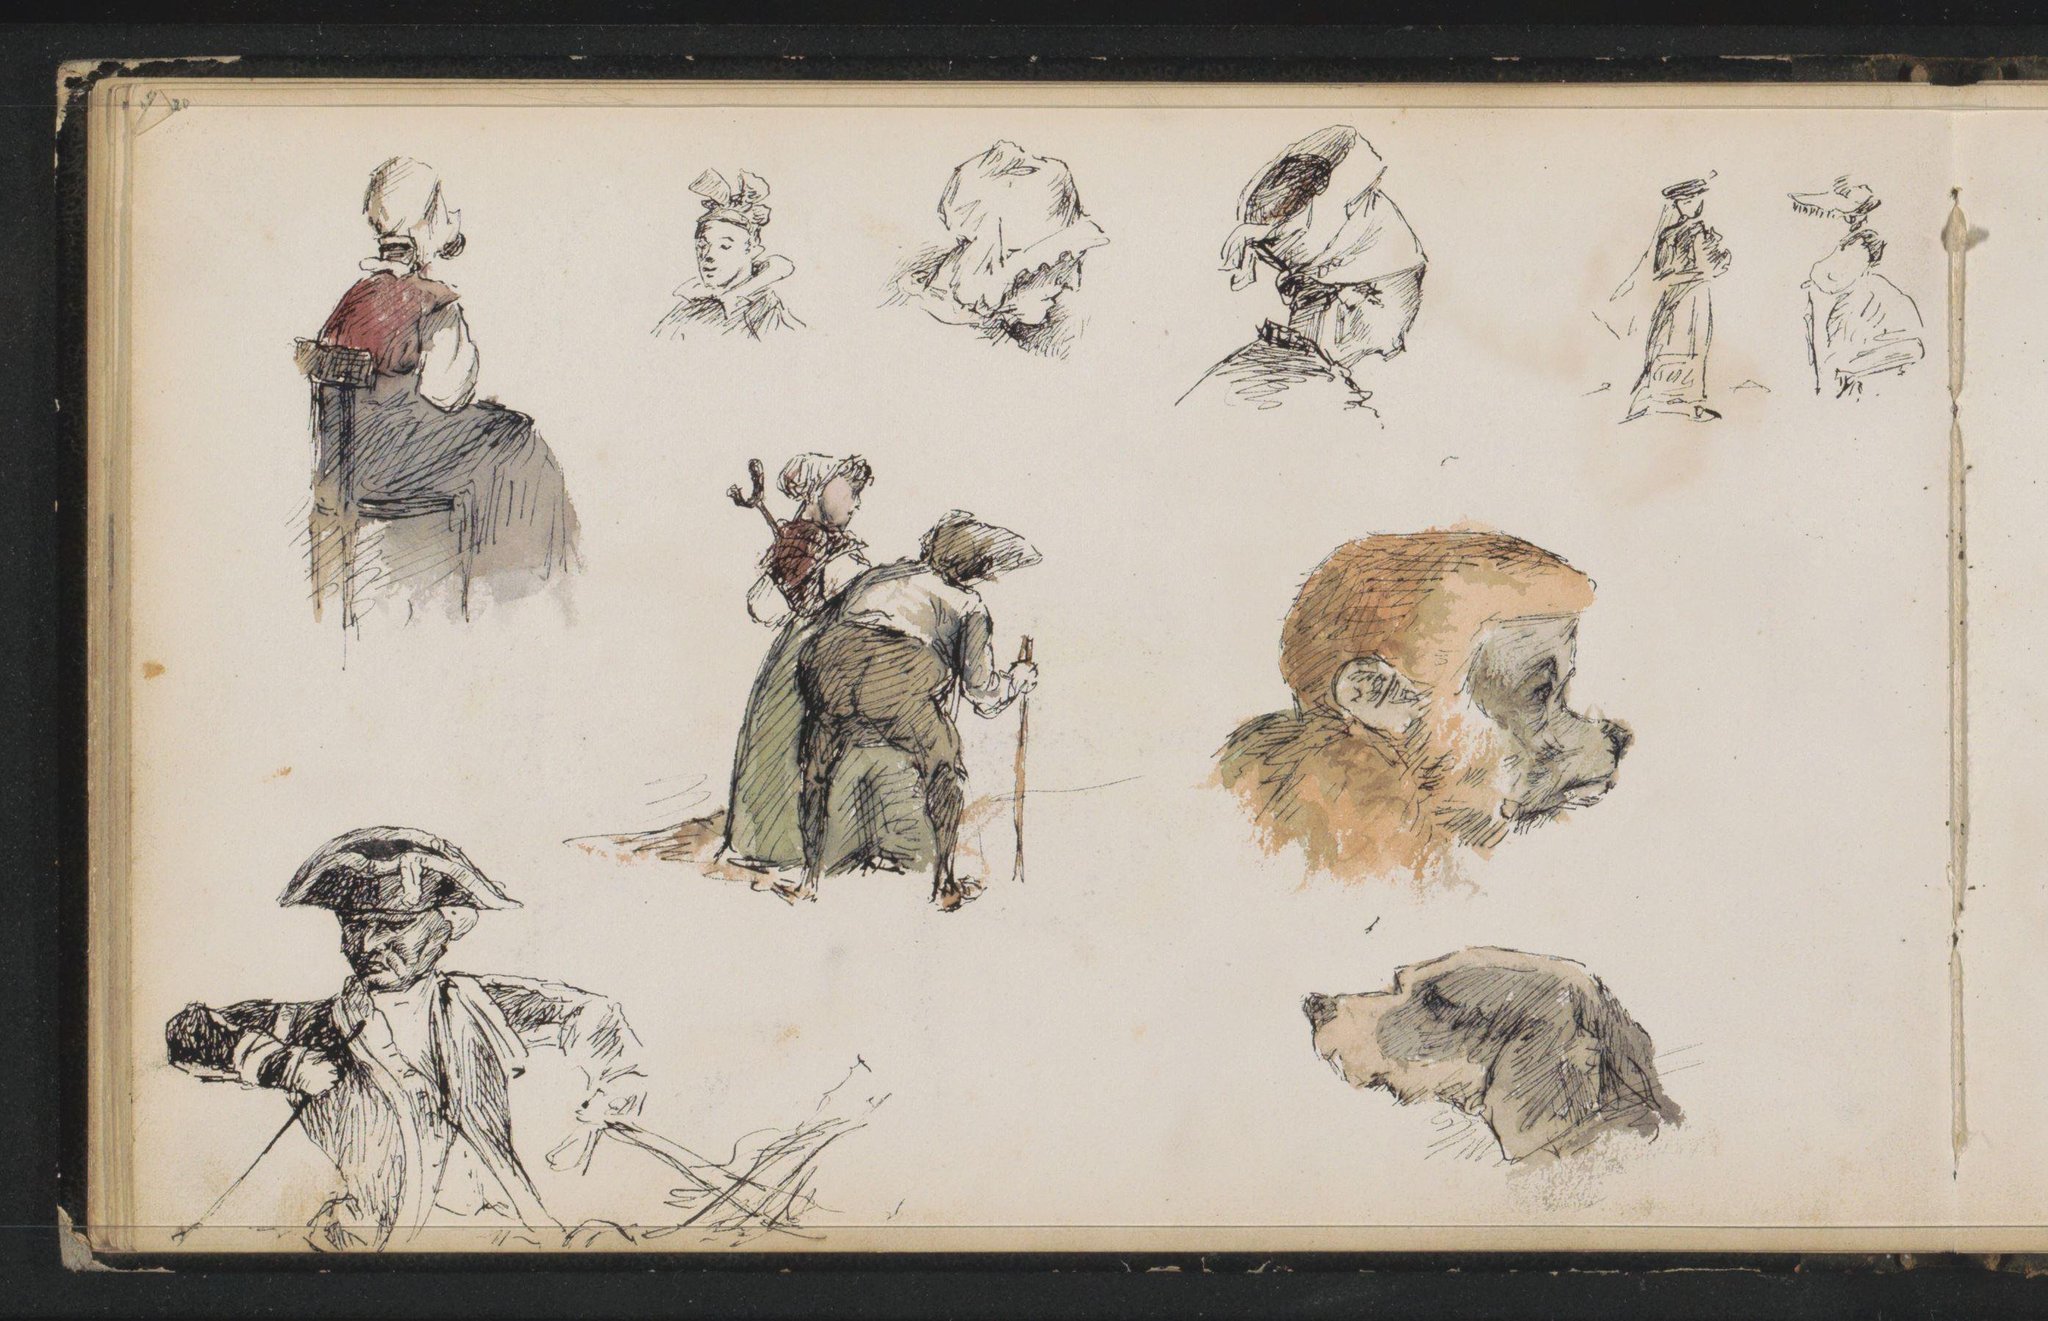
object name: sketchbook leaf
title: Figuur- en dierstudies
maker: marius bauer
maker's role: draughtsman, print maker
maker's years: 1867-1932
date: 1812-1880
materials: paper, watercolor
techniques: brush, pen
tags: riding a horse, ass, or mule; rider, horseman, adult woman, head-gear, monkeys, apes, dog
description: Voornamelijk studies van vrouwfiguren met verschillende hoofddeksels en een militair te paard. Tevens twee koppen van een aap en hond. Pagina 20 uit een schetsboek met 34 bladen.